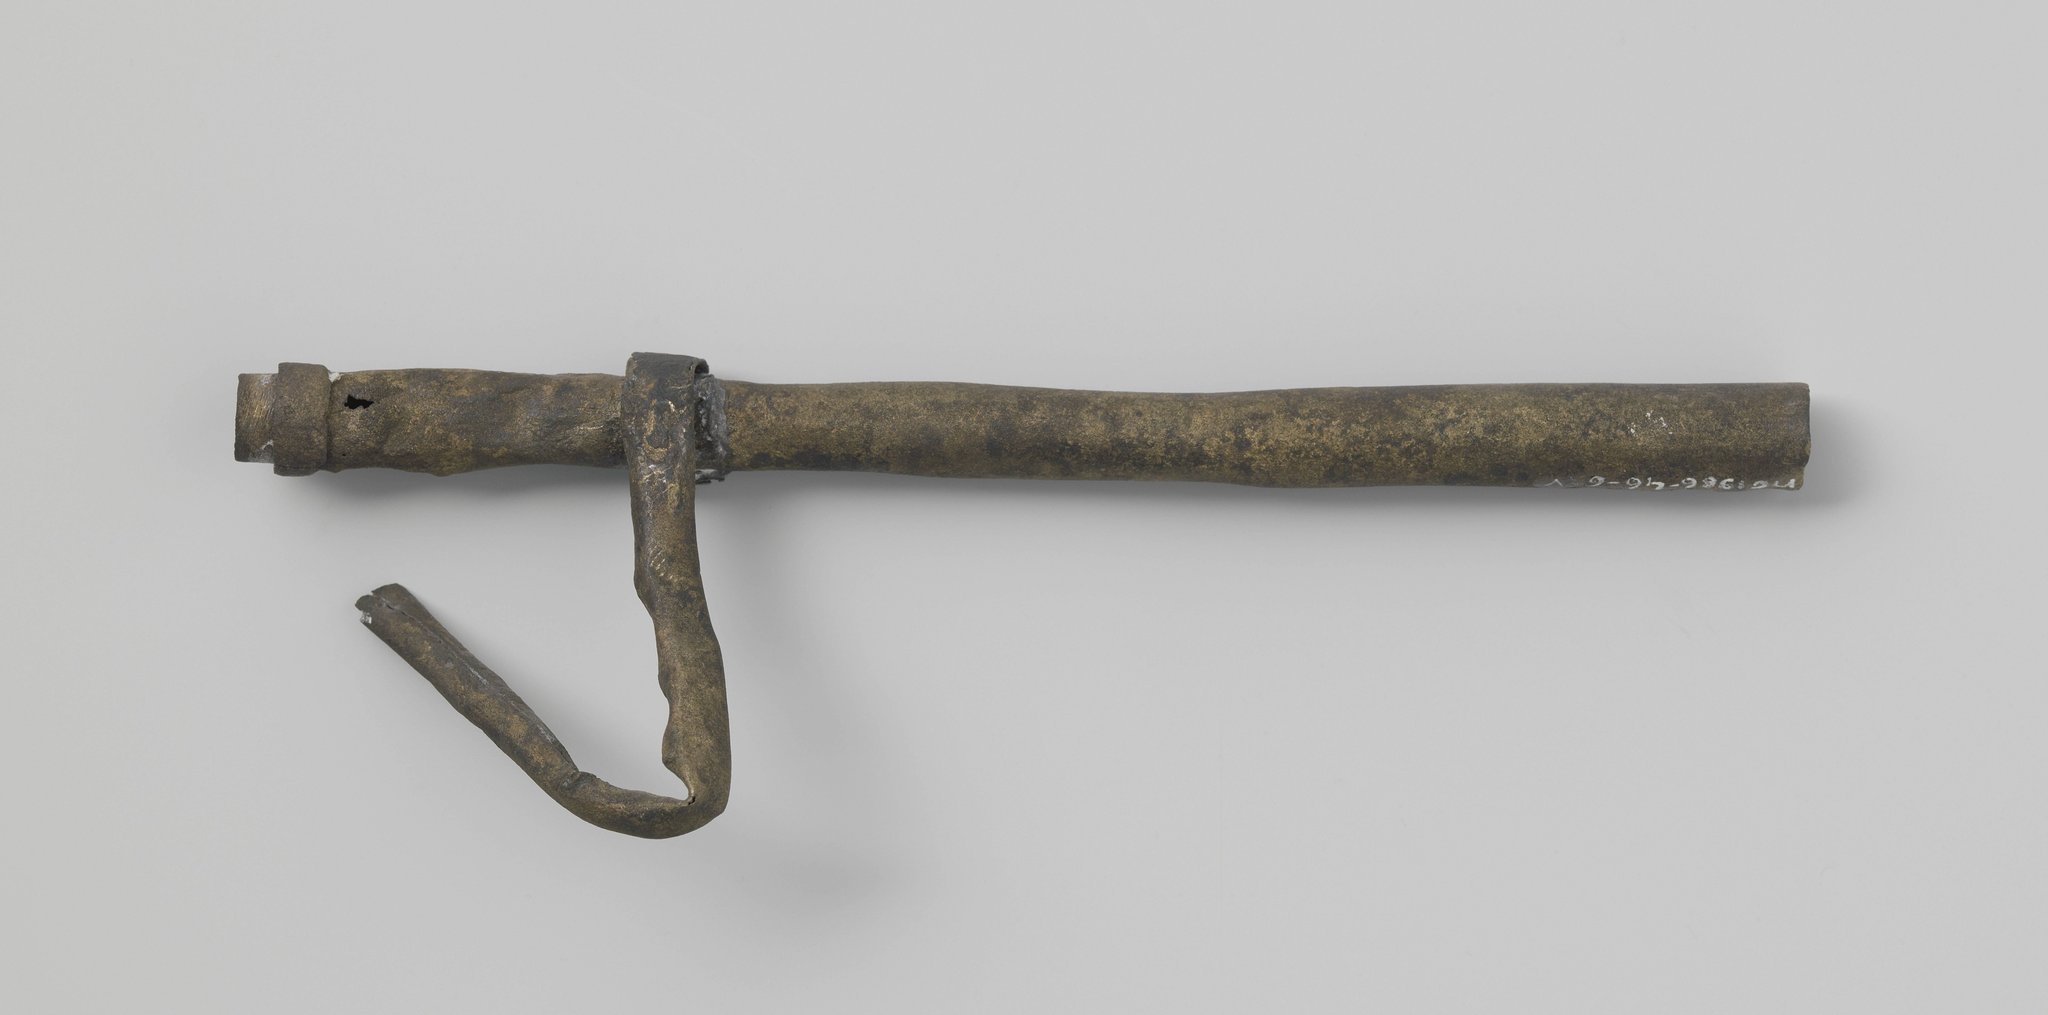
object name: natural trumpet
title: Part of a natural trumpet from the wreck of the Dutch East India ship Hollandia, made by Georg Friedrich Steinmetz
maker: georg friedrich steinmetz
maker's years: 1668-1740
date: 1700-1735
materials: brass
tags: 't vliegend hart (schip), verenigde oostindische compagnie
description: Ronde dunne buis met naad (deels open) over de gehele lengte. Op een derde van de lengte zit dwars hieromheen een vervormde buis die geknikt is. Een strip is om de bovenzijde van de buis vastgemaakt.